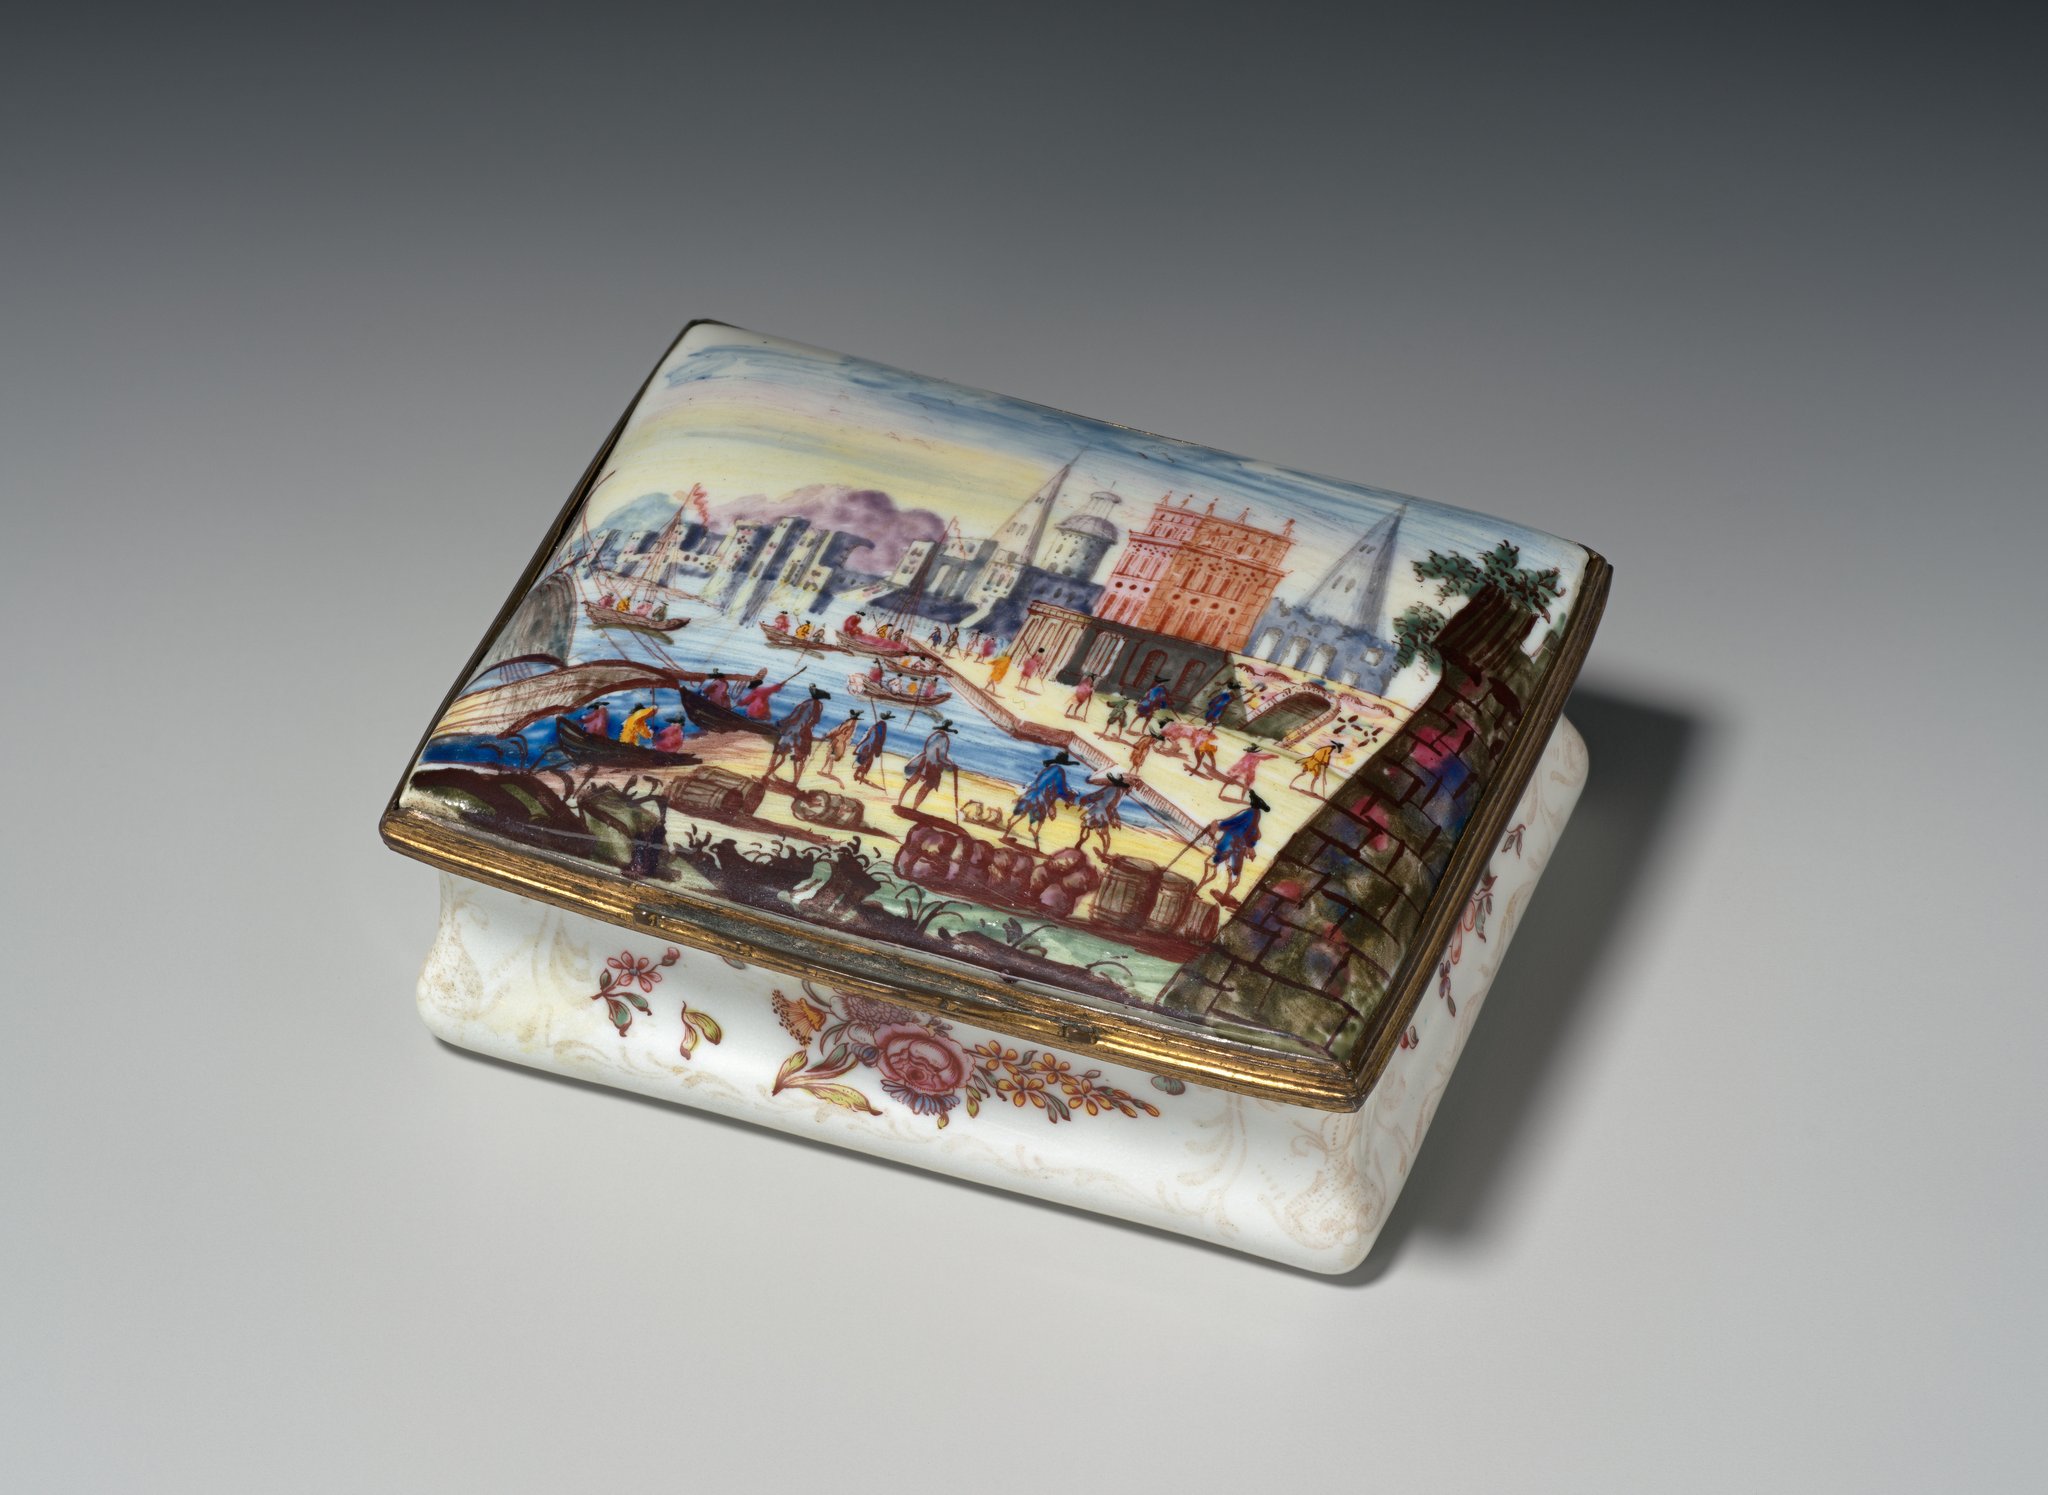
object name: snuffbox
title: Snuffbox with harbor scene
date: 1765-1770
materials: copper, enamel